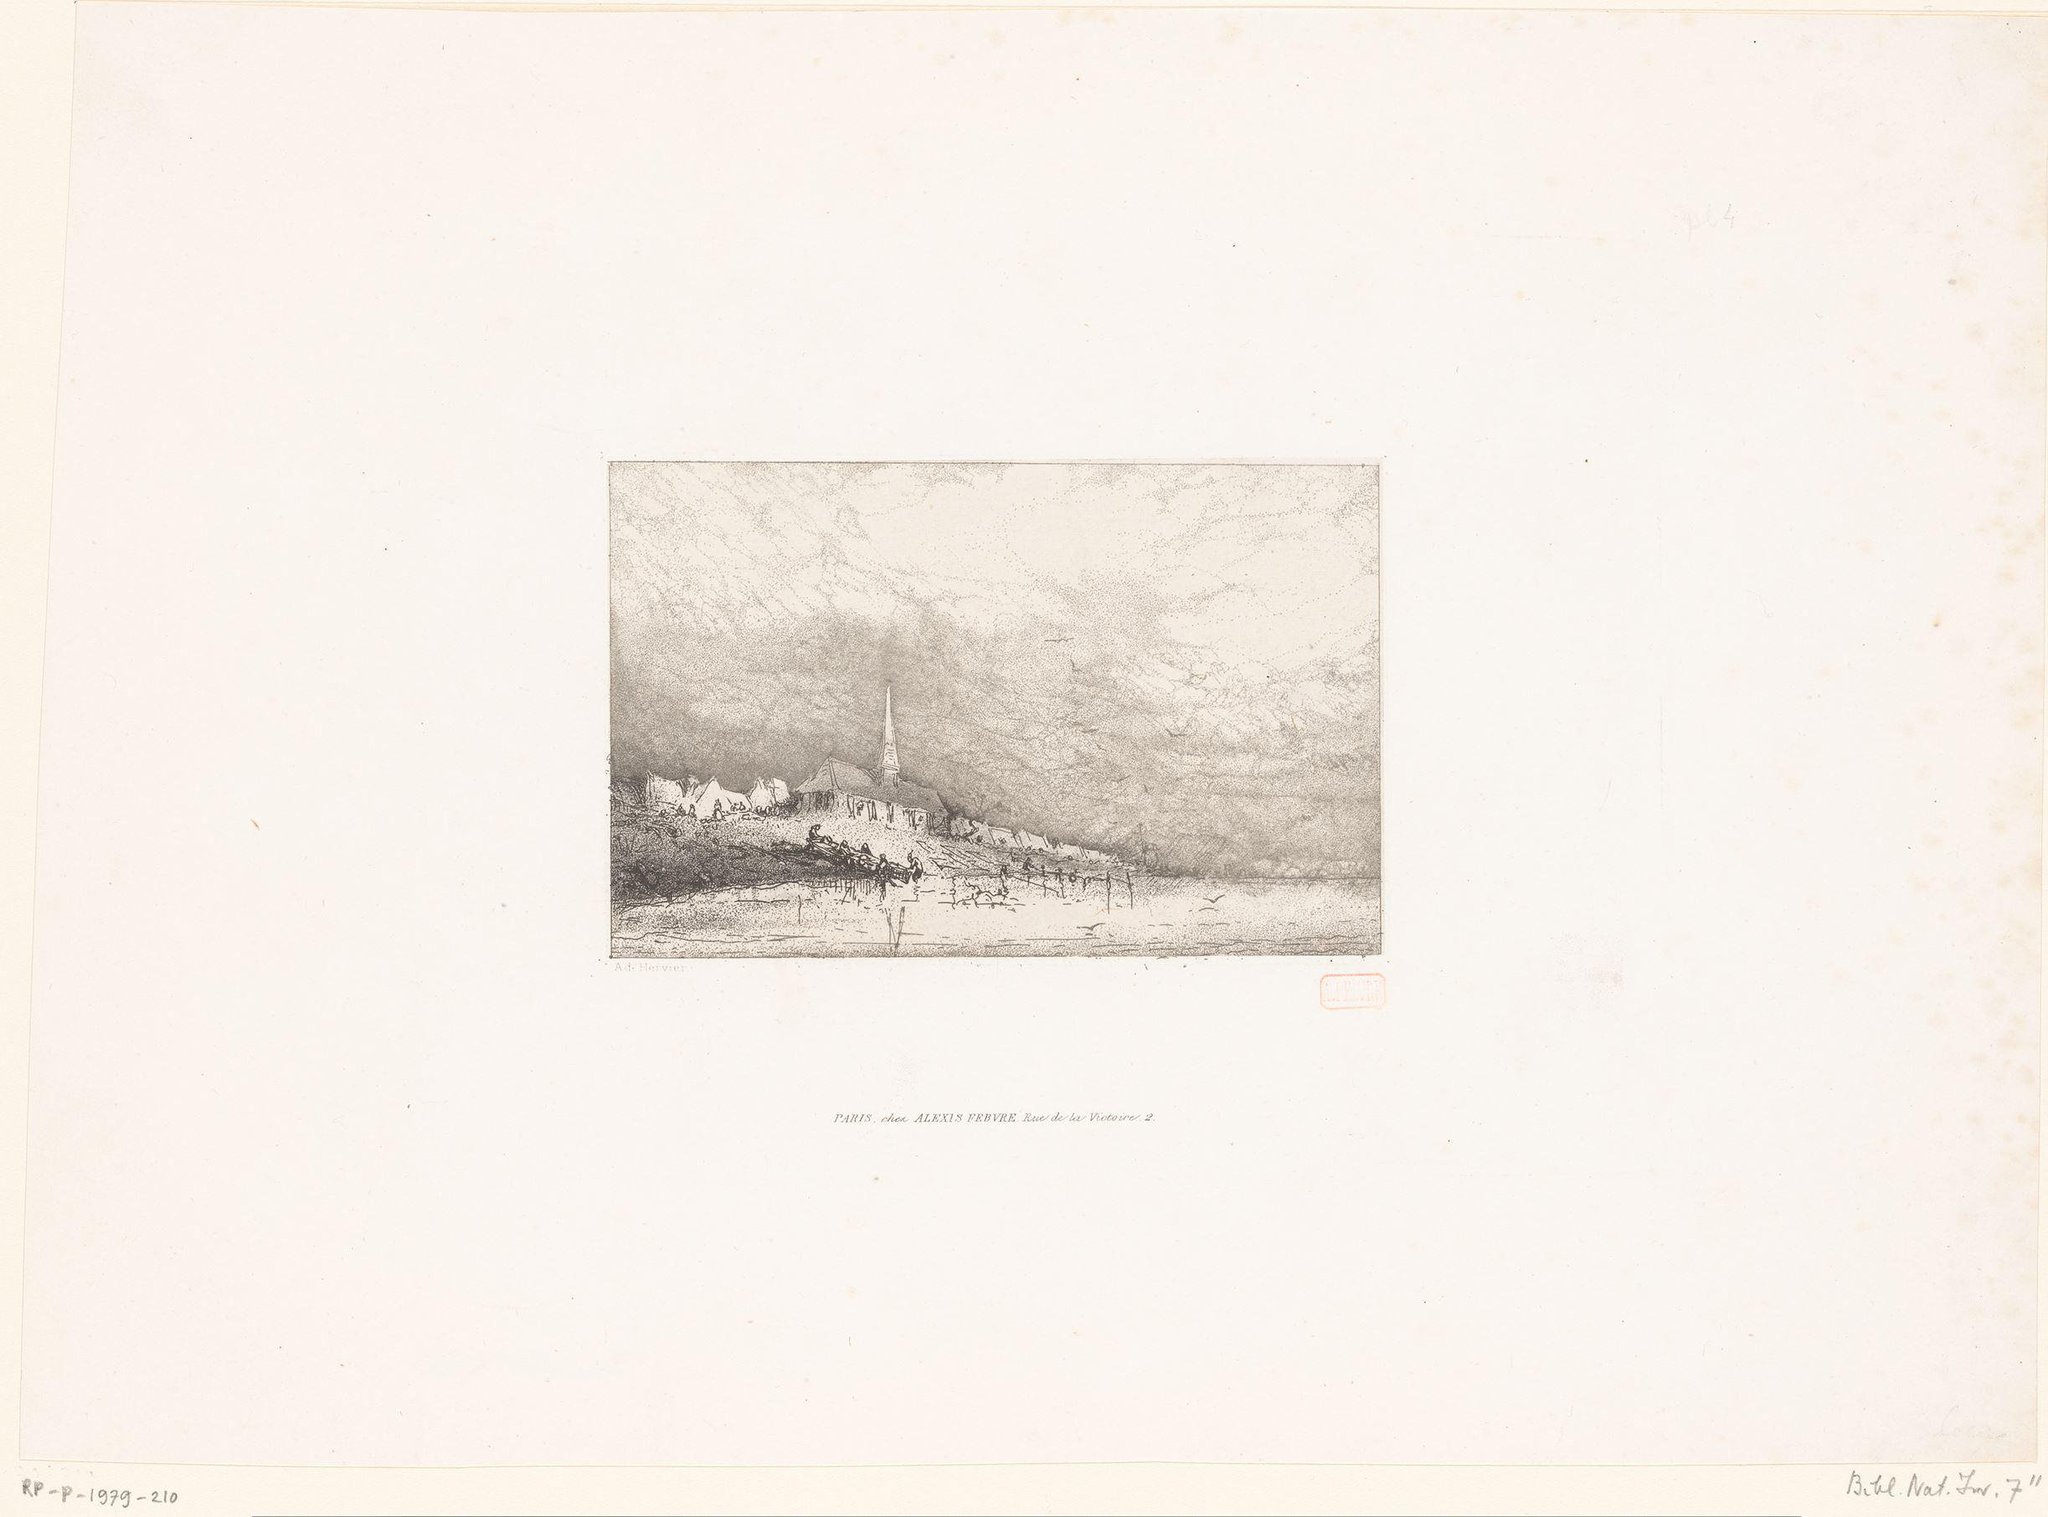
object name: print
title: Verschillende landschappen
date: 1843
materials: paper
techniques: aquatint, etching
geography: paris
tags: prospect of village, silhouette of village, beach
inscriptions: collector's mark: Lugt 2228, collector's mark: Lugt 2760, stamp: Lugt 922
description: Maakt deel uit van een achtdelige serie met landschappen uit 1843.